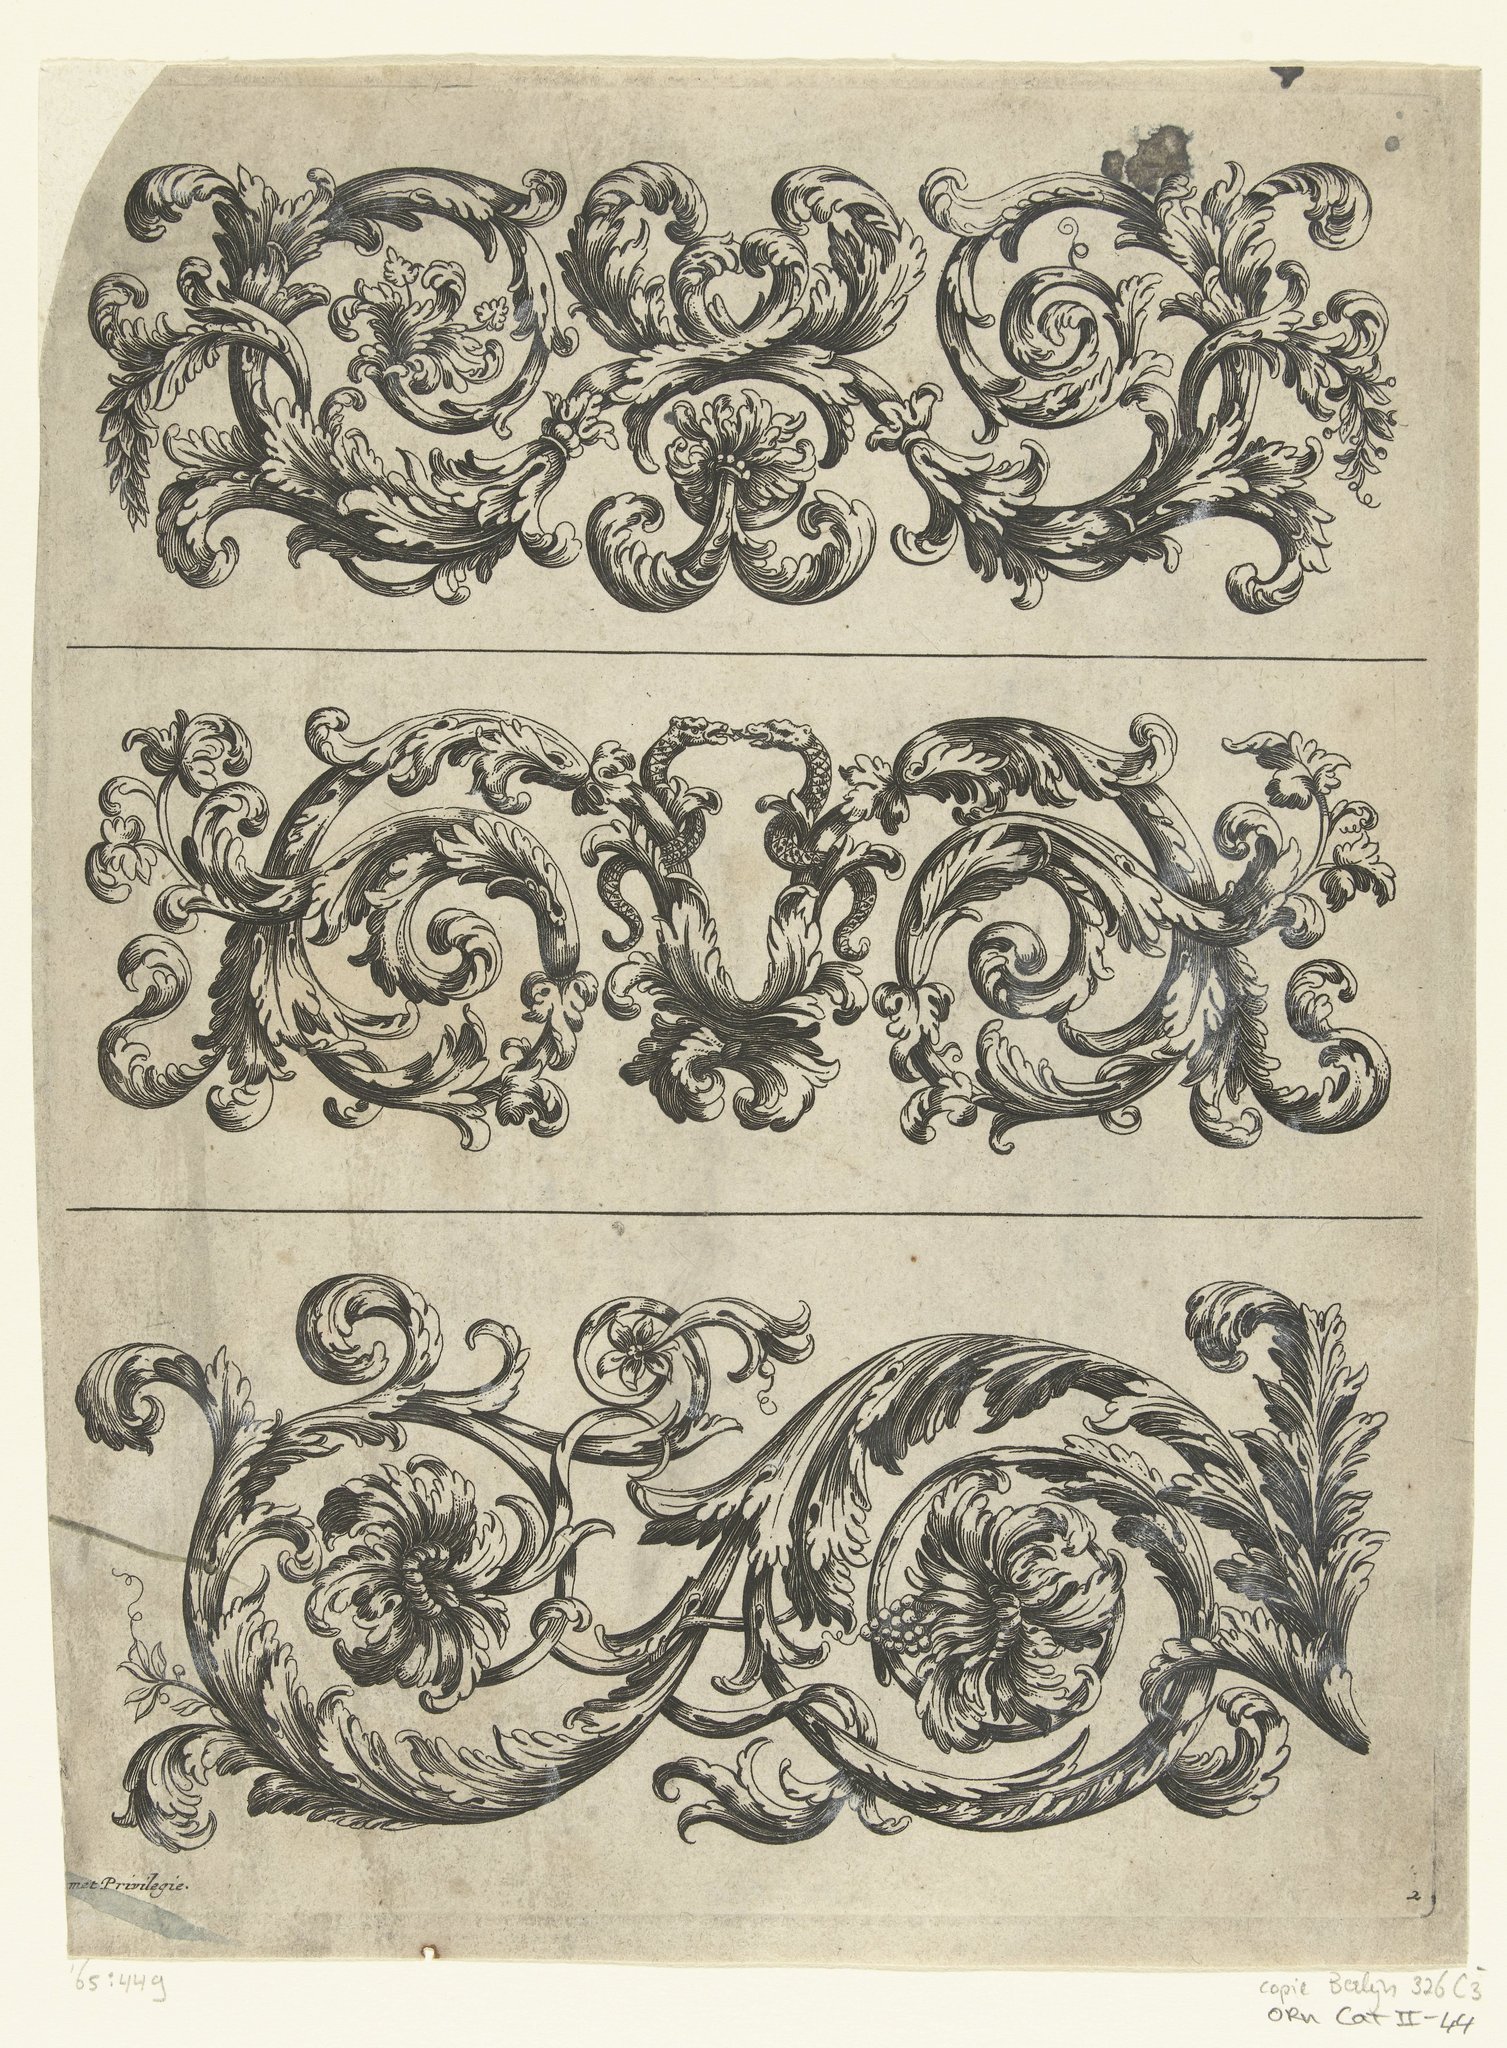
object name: ornament print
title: Drie friezen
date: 1680-1700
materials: paper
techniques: etching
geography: amsterdam